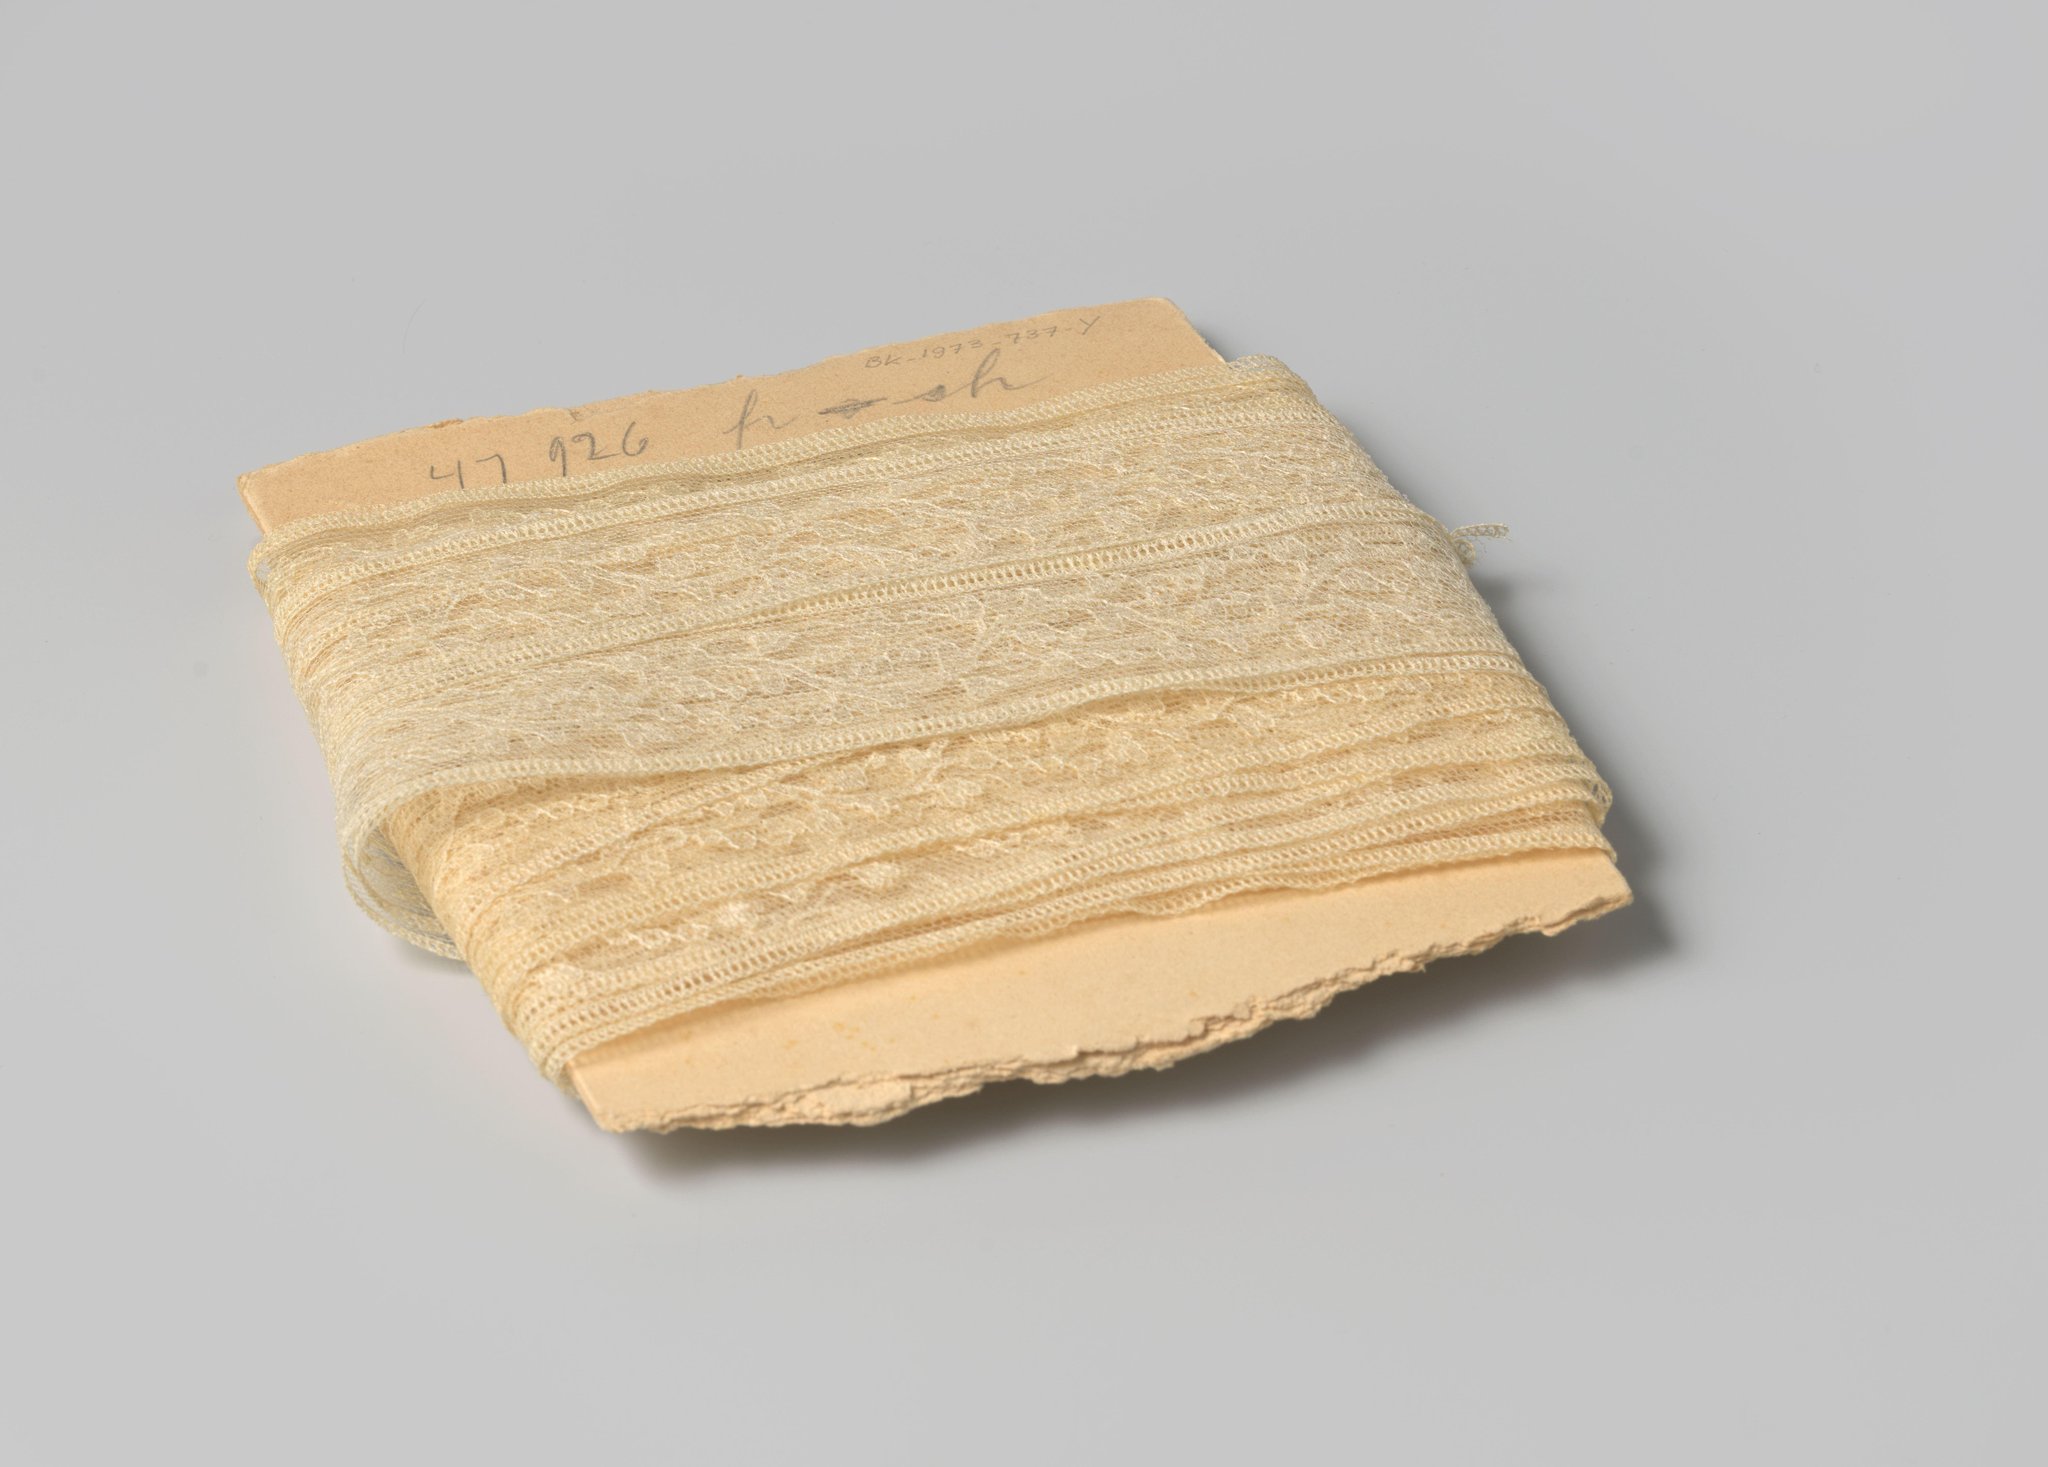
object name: strip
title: Tussenzetsel van roomwitte machinale kant met patroon van doorlopende bladrank, op karton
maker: gustav schnitzler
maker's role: paraplufabrikant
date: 1925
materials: cardboard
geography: nijmegen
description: Tussenzetsel van roomwitte machinale kant met patroon van doorlopende bladrank, op karton.